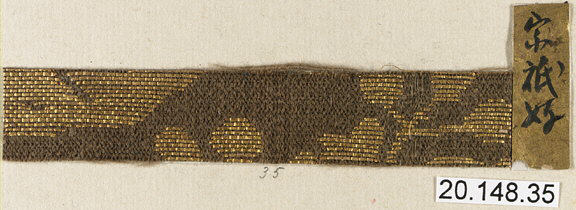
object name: piece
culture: japanese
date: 1501-1600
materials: silk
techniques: compound weave